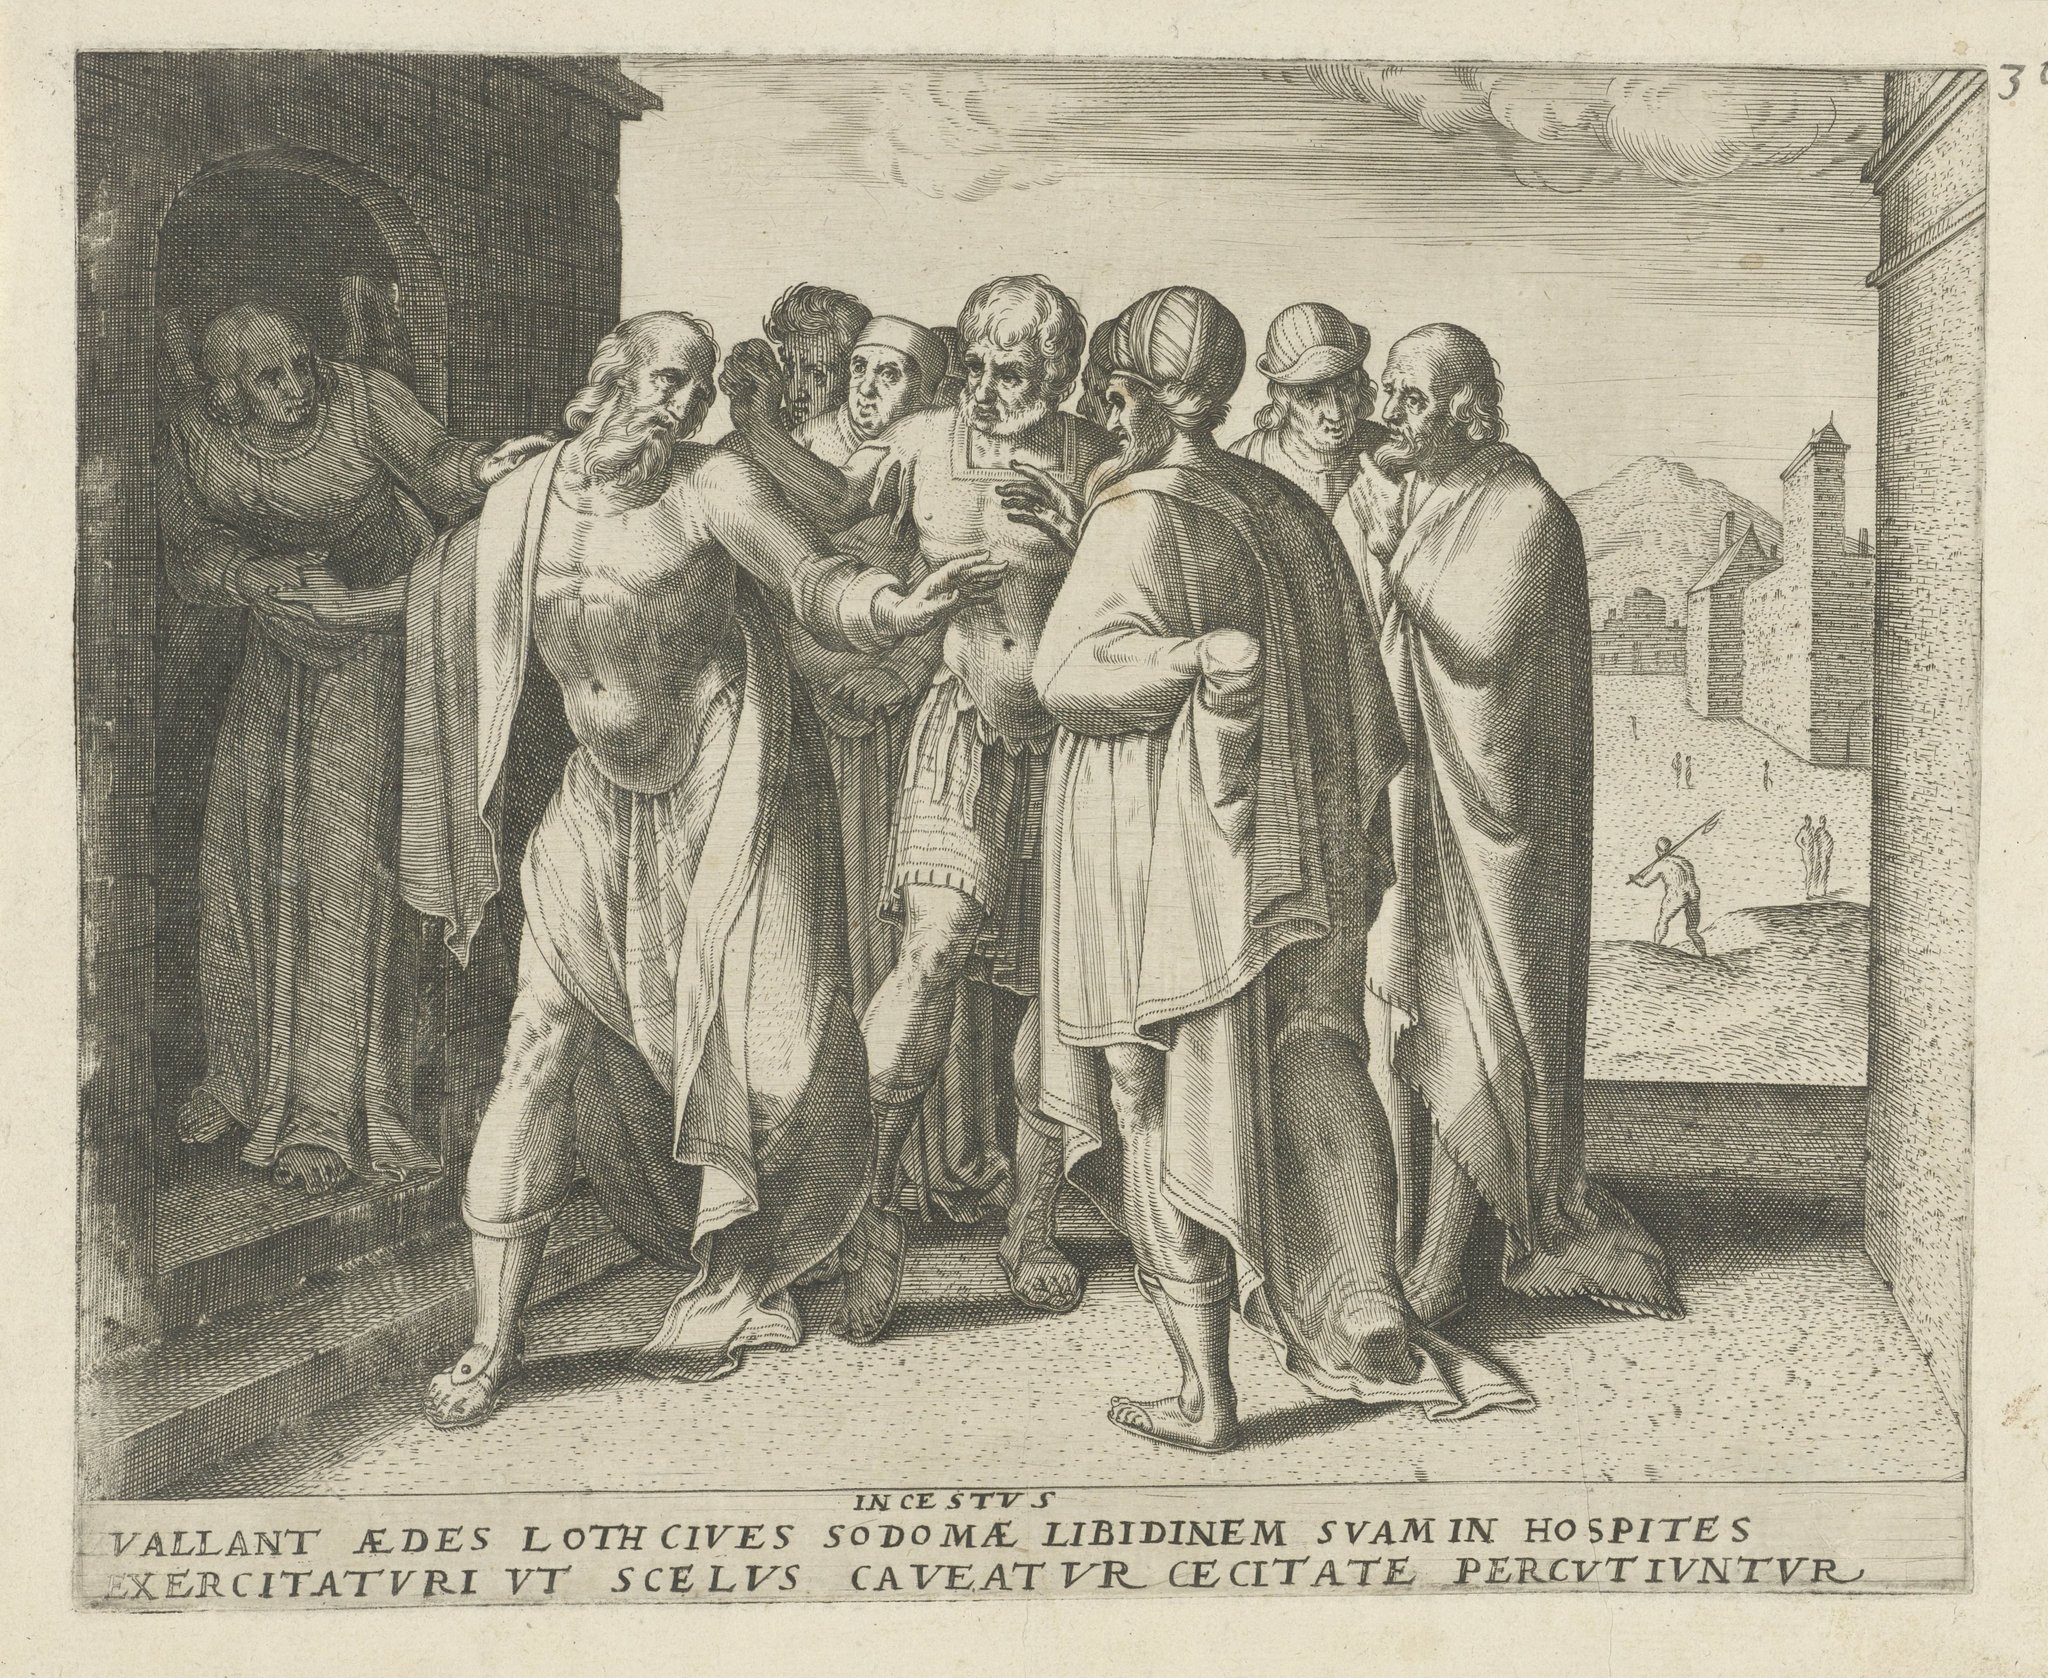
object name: print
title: Incestus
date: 1550-1570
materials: paper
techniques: engraving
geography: antwerp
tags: lot tries to pacify the mob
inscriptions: collector's mark: Lugt 2228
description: Dit is de eerste staat van twee van de eerste editie van deze prent, die mogelijk door Hieronymus Cock werd uitgegeven. De plaat kwam, vermoedelijk na de dood van Cock, in handen van Gerard de Jode. De voorstelling van de plaat werd toen compleet verwijderd en er kwam een iets andere compositie voor in de plaats. Alleen de tekst bleef ongewijzigd. De plaat werd vervolgens gebruikt in: Thesaurus sacrarum historiaru veteris testamenti, elegatissimis imaginibus expressu excelletissimoru in hac arte viroru opera : nuc primu in luce editus. Antwerpen: Gerard de Jode, 1579. Van die tweede editie, toegeschreven aan Hans Collaert (I), bestaan drie staten.